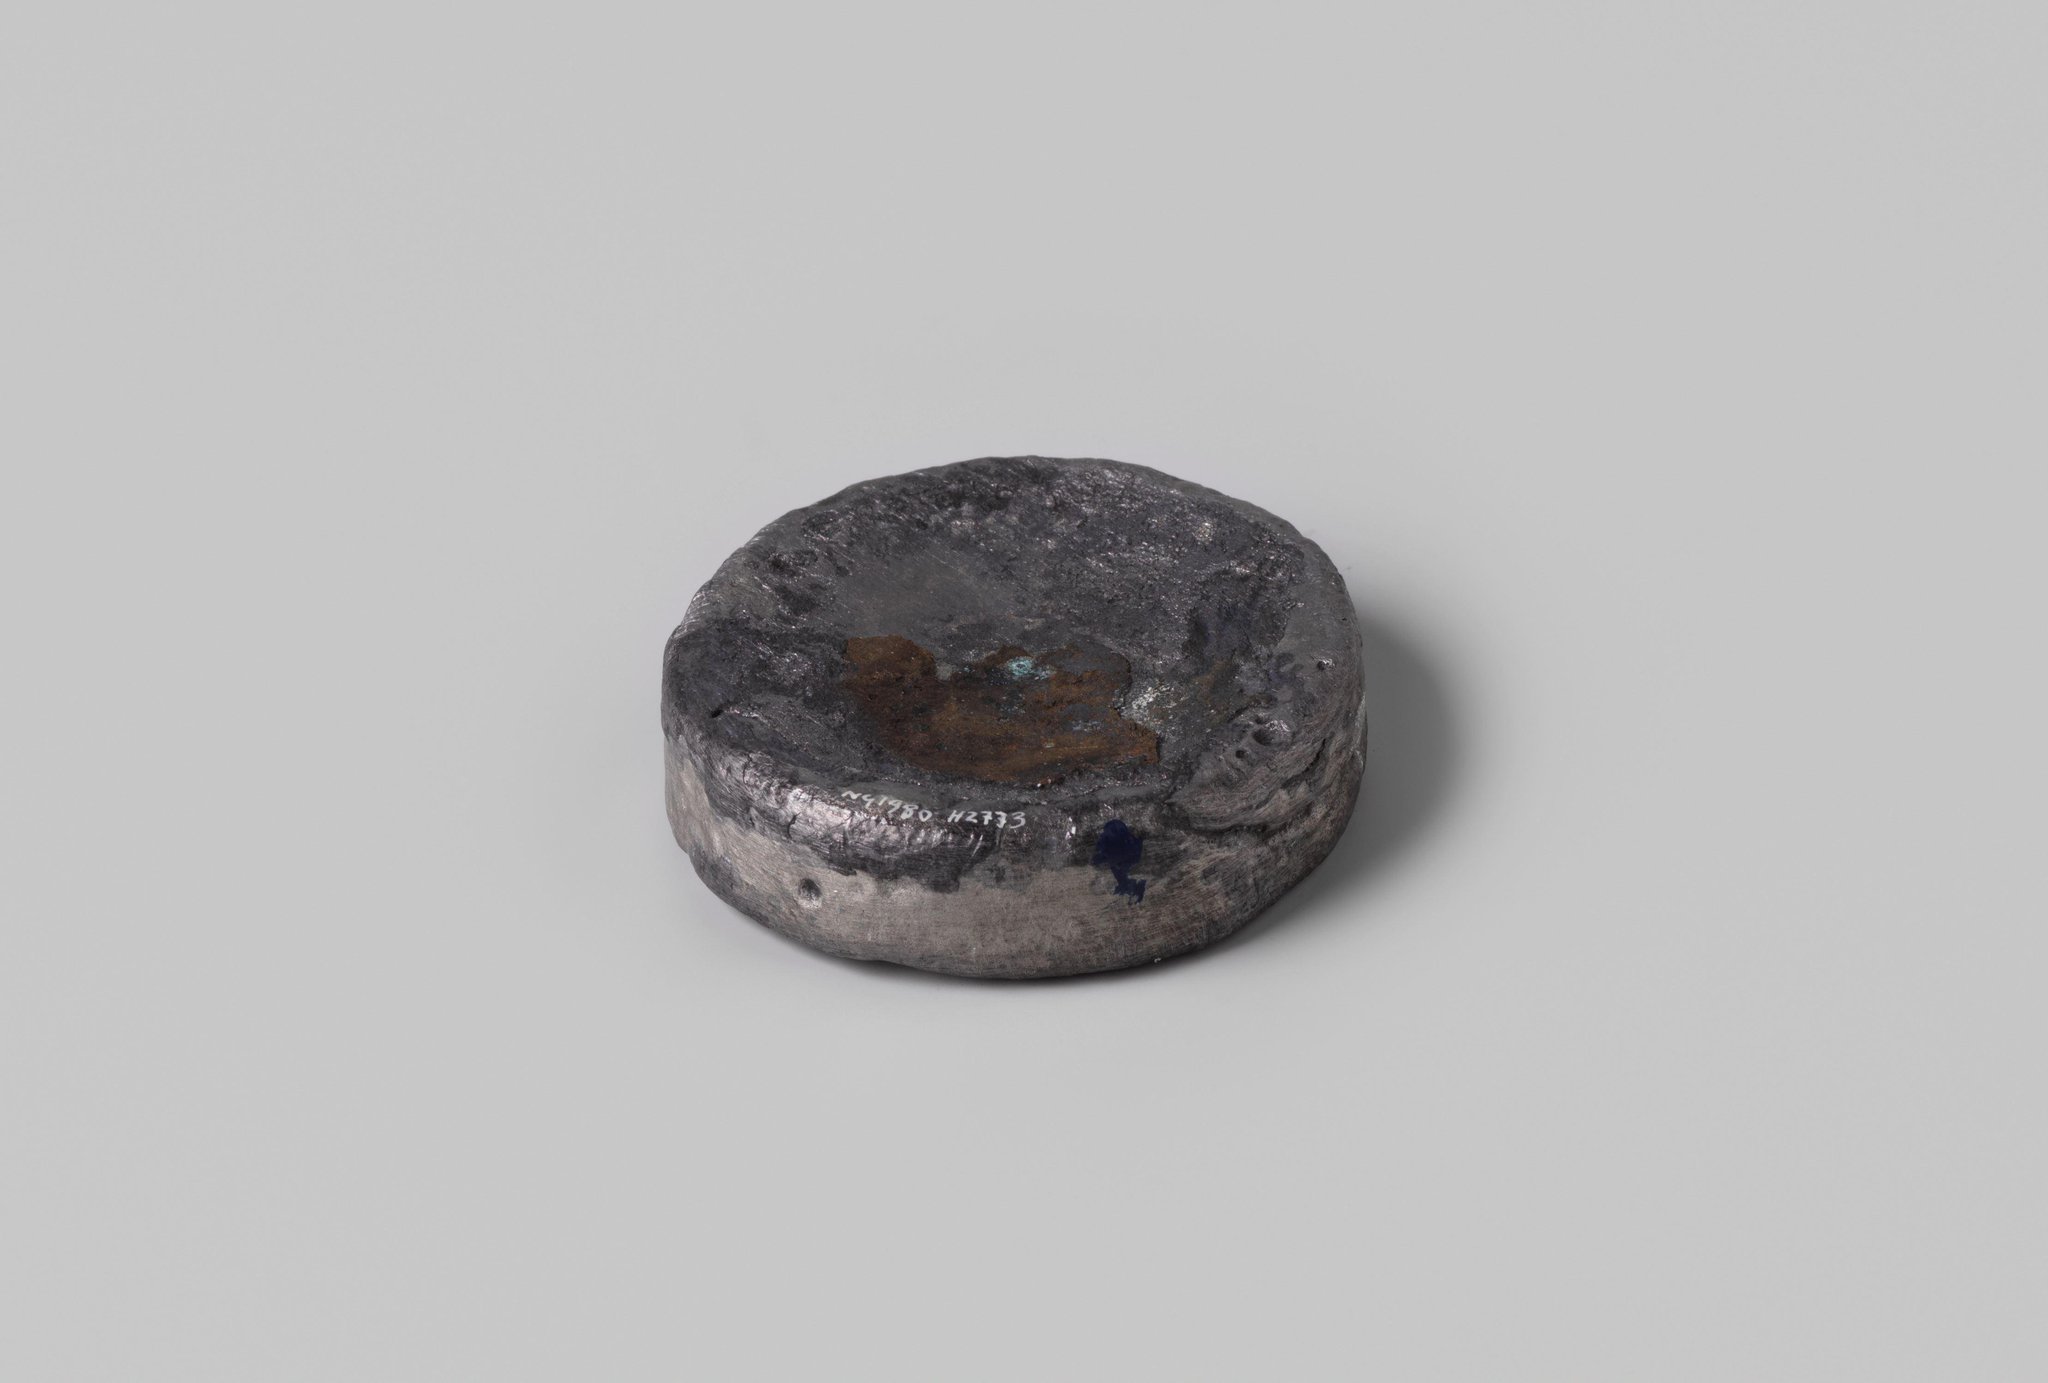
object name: weight scale component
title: Disc-shaped weight, lead, from the wreck of the Dutch East India ship Hollandia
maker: Anonymous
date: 1700-1743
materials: lead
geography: netherlands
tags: verenigde oostindische compagnie, hollandia (schip), annet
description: Disc-shaped weight, circular, concave top and underside, eroded, on surface fragm of hard, thin metal layer (coating?).